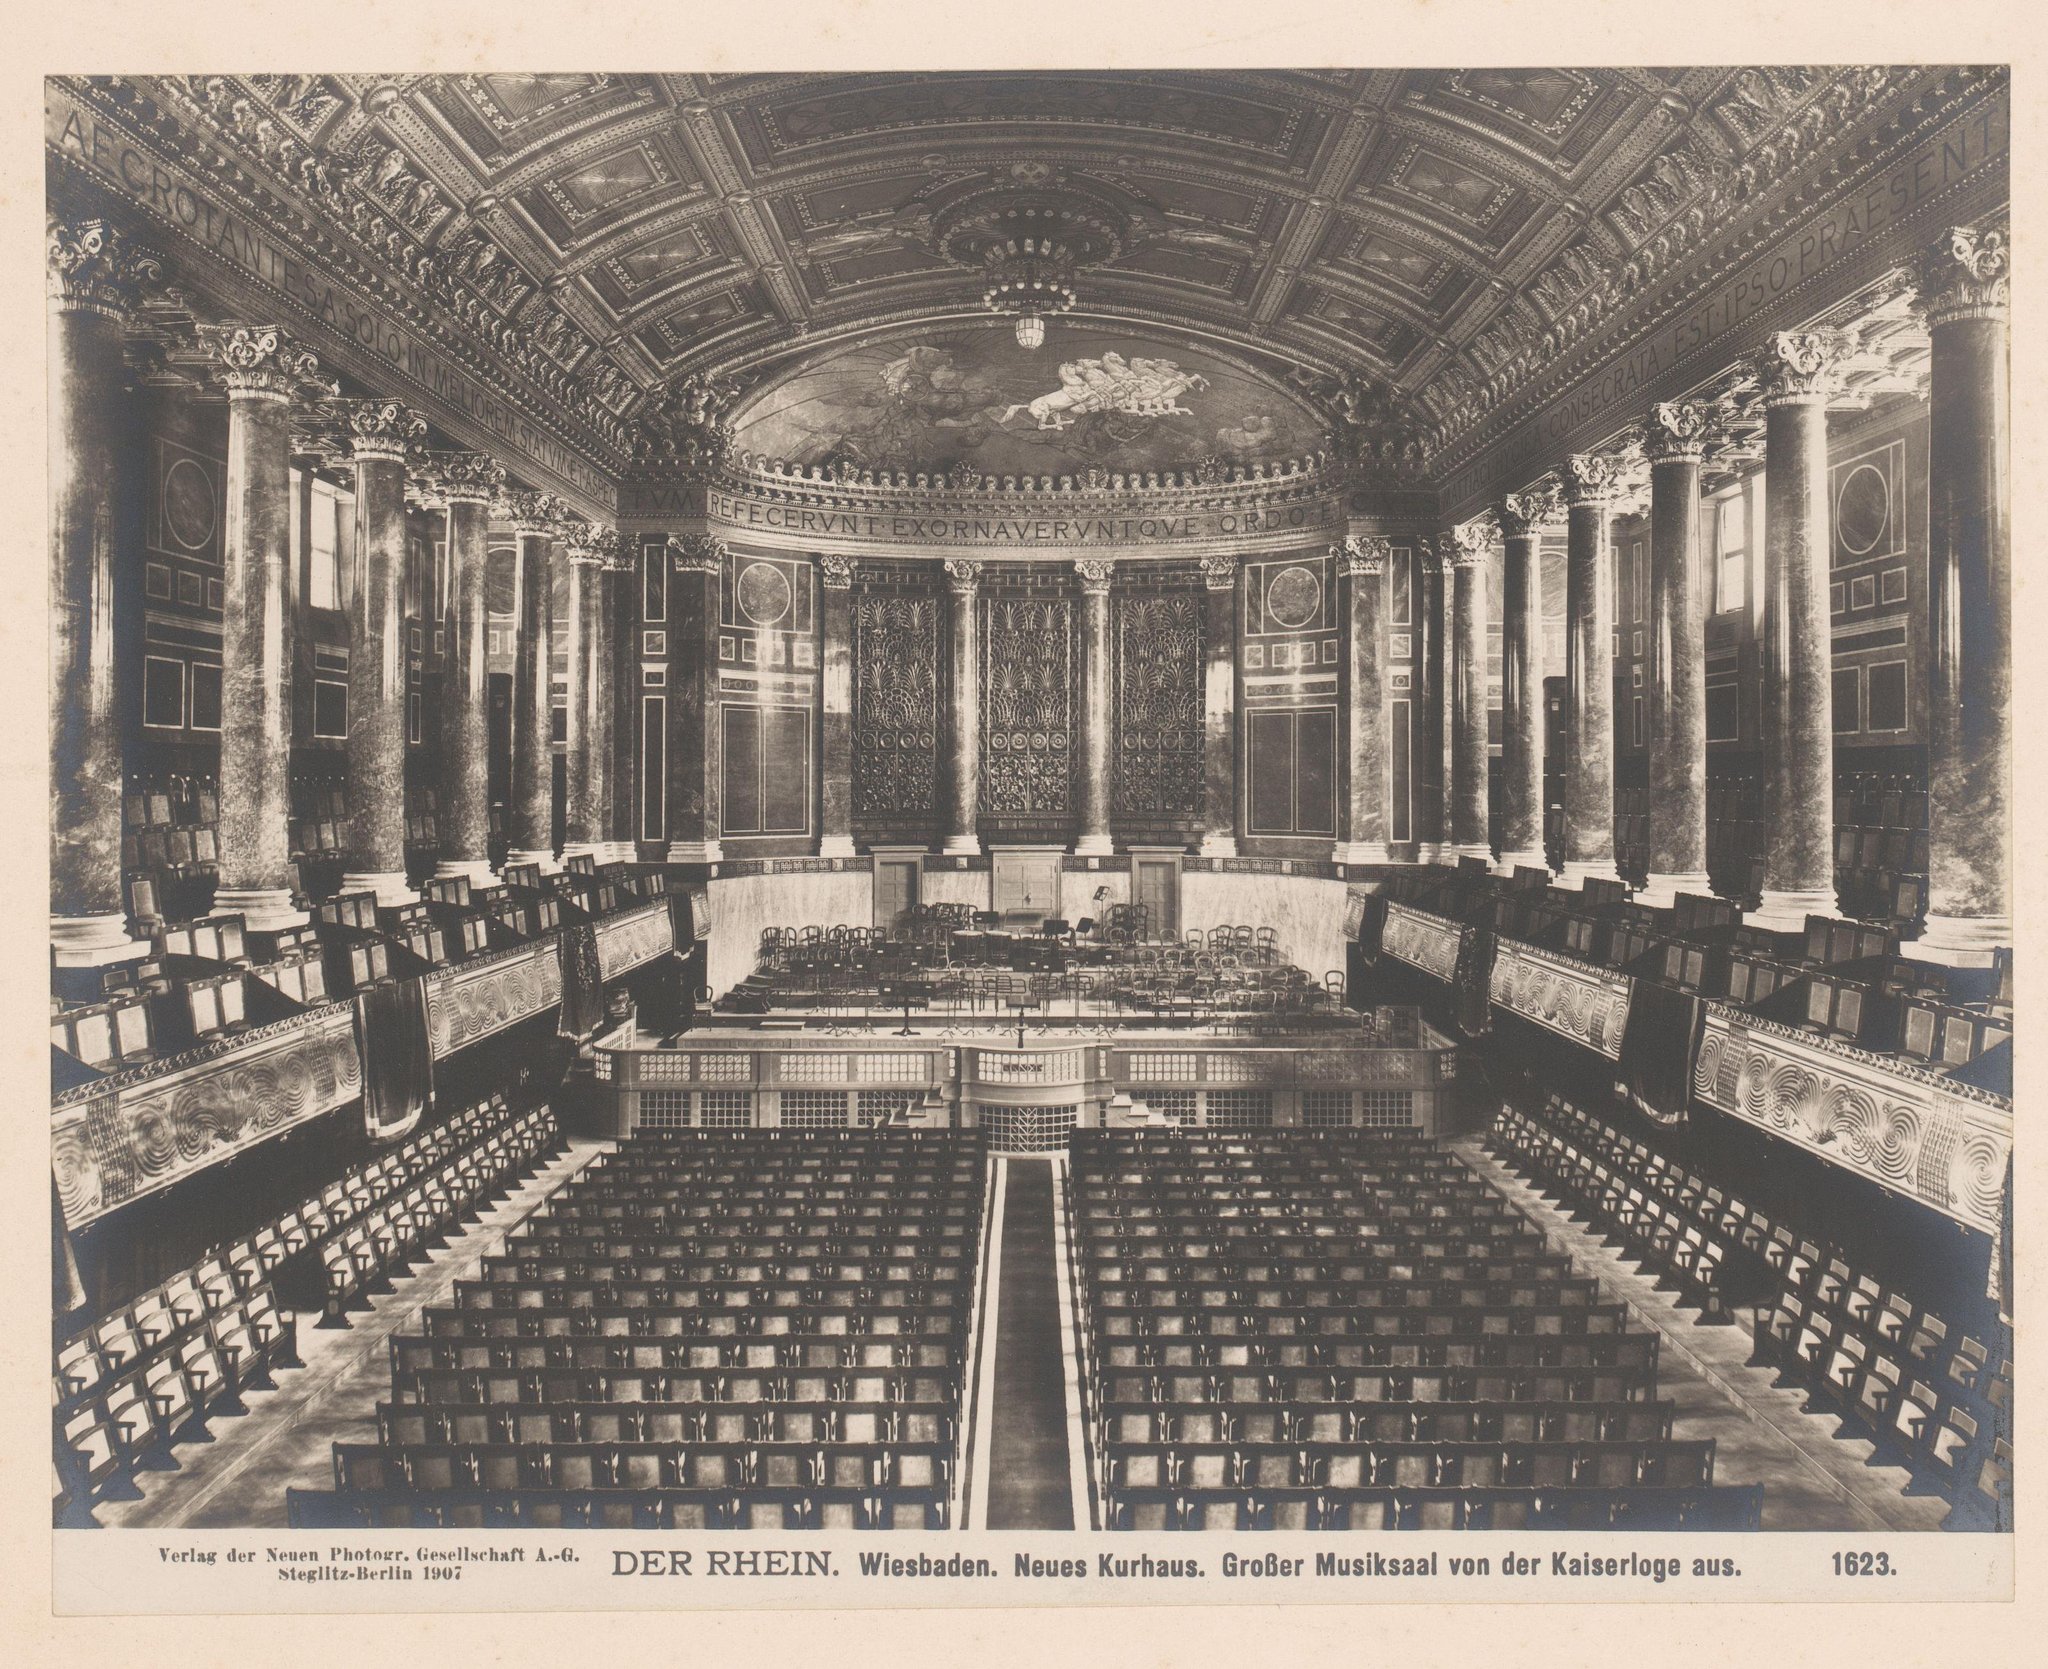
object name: photograph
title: Der Rhein. Neues Kurhaus, Grosser Musiksaal von der Kaiserloge aus, Wiesbaden, Duitsland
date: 1907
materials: cardboard, paper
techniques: albumen print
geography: berlin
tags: wiesbaden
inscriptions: caption: ‘DER RHEIN. Wiesbaden. Neues Kurhaus. Grosser Musiksaal von der Kaiserloge aus.’, name: ‘Neue Photographische Gesellschaft A. G.//Steglitz-Berlin 1907’, number: ‘1623.’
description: Der Rhein. Neues Kurhaus, Grosser Musiksaal von der Kaiserloge aus, Wiesbaden, Duitsland.